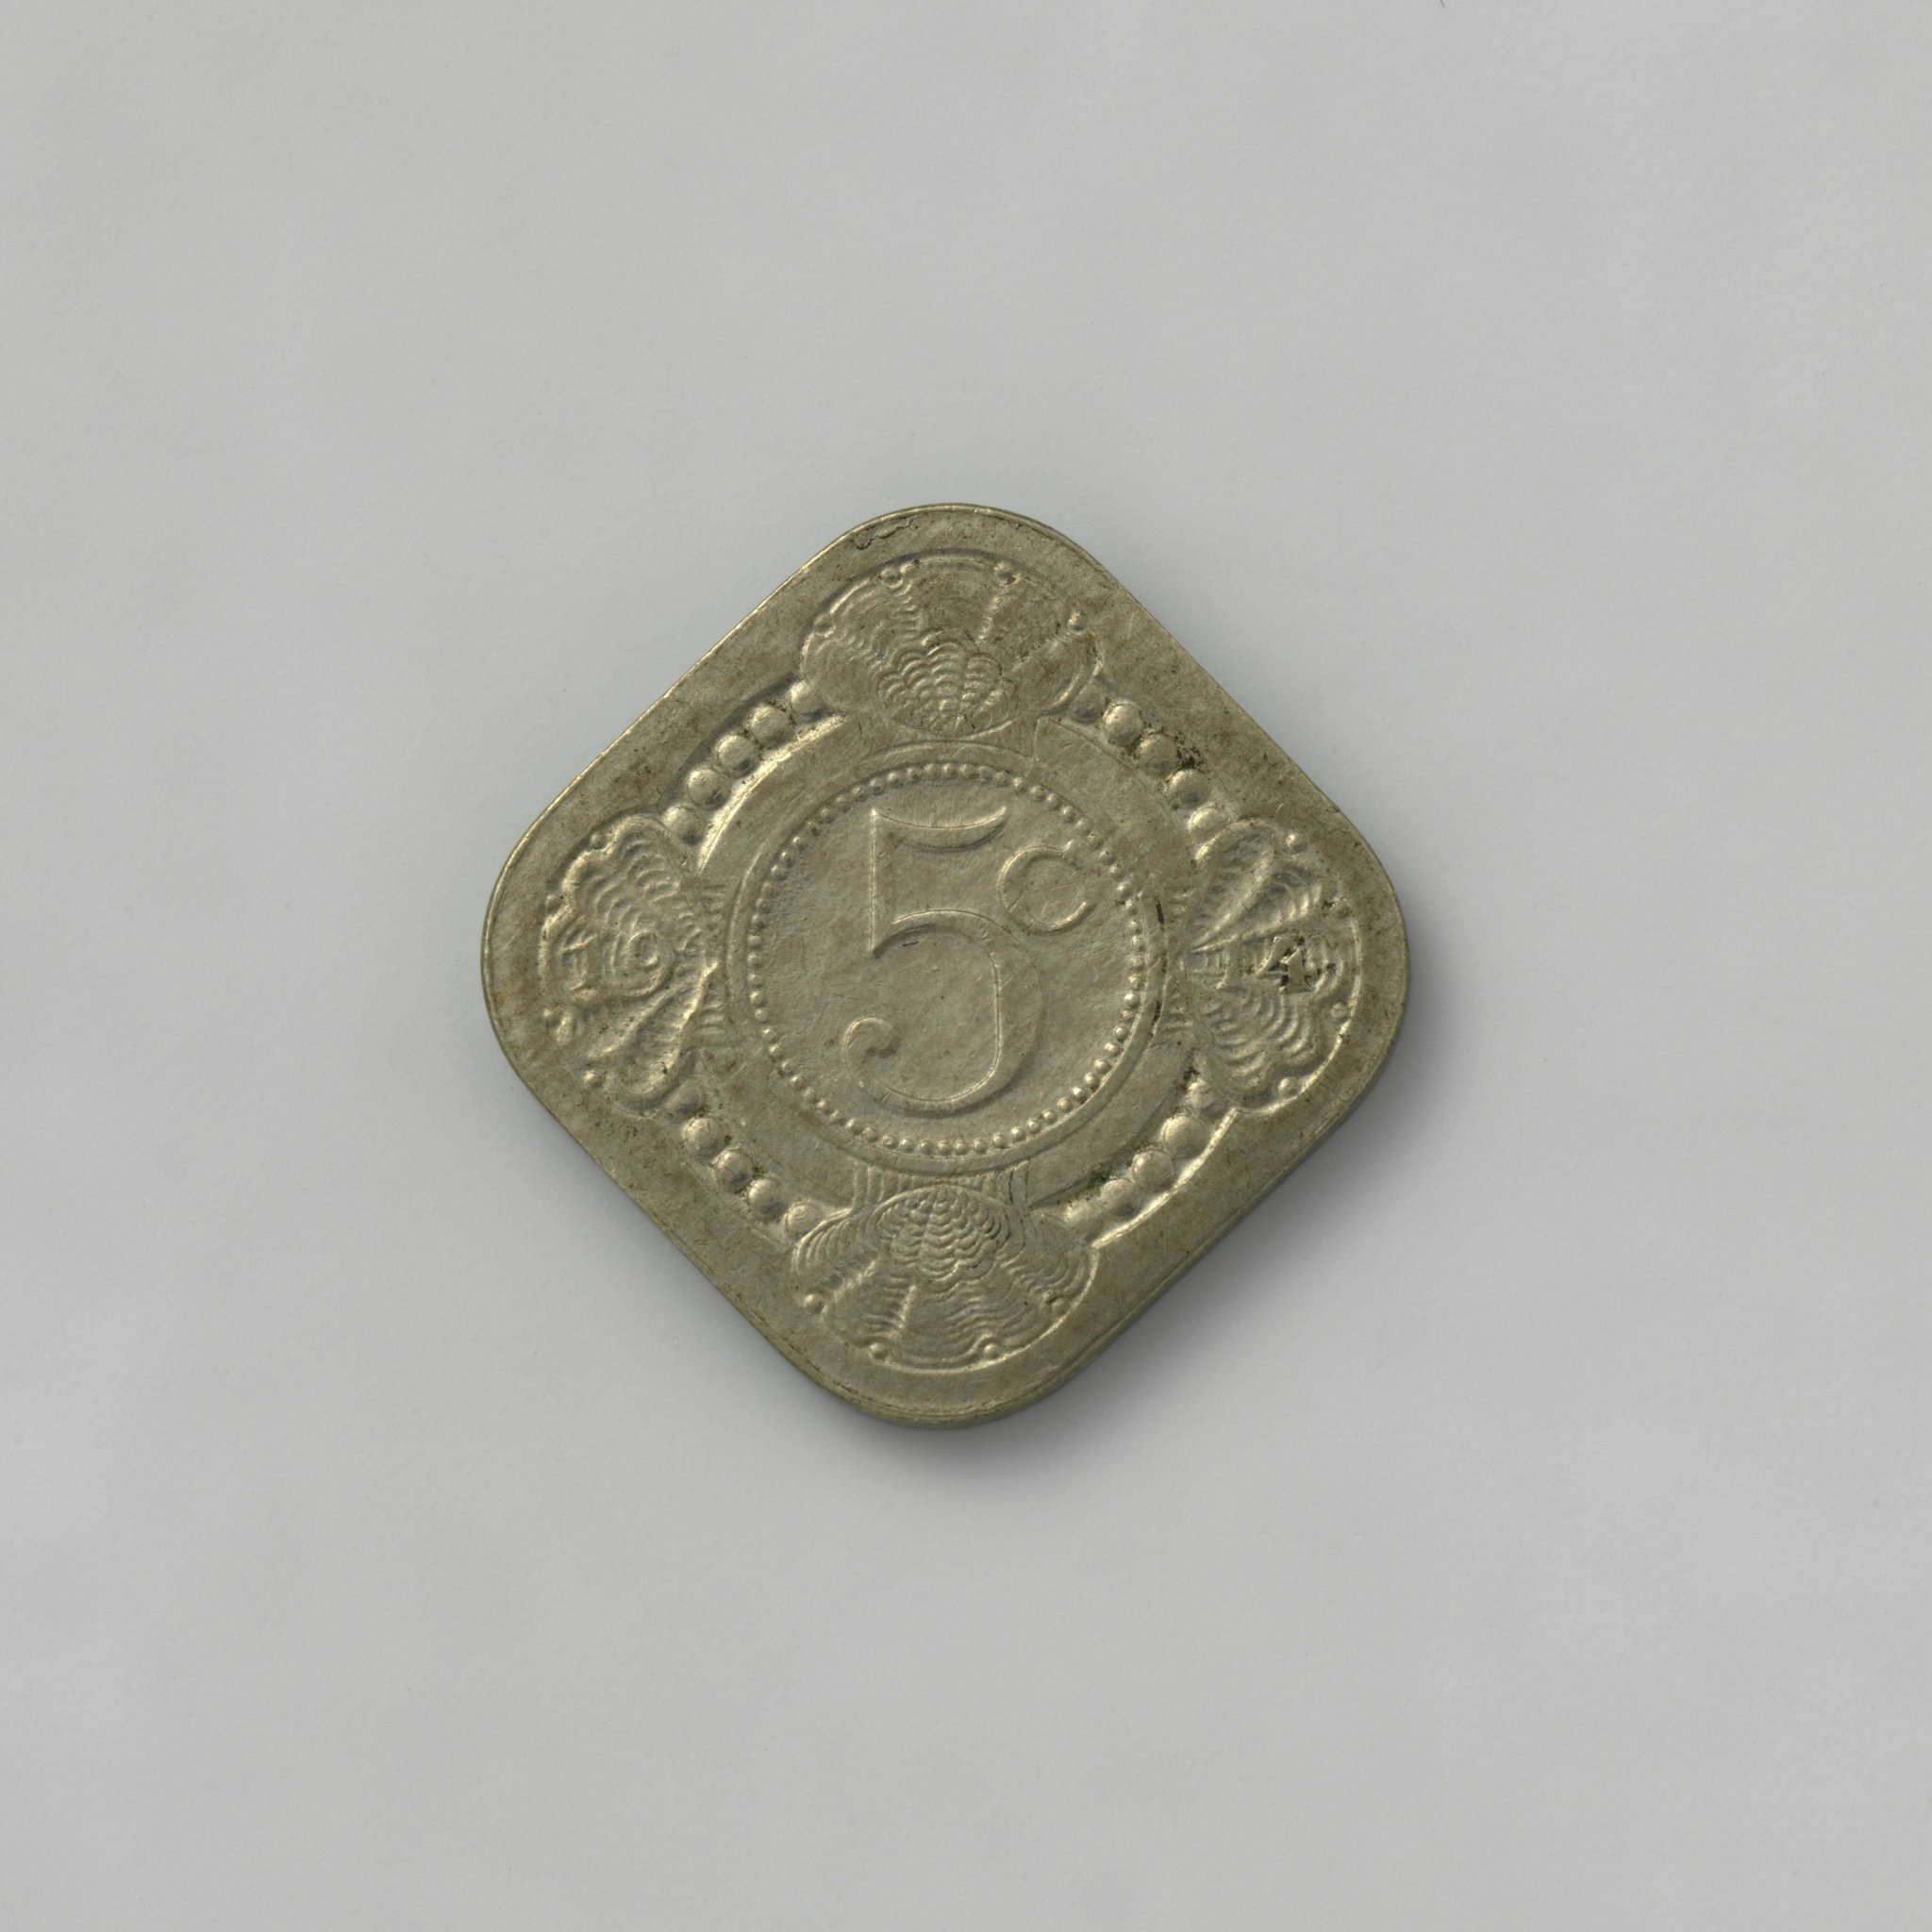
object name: vijf cent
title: Nederland, 5 cent, 1914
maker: wilhelmina of the netherlands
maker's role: print maker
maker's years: 1880-1962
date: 1914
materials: nickel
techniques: striking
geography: utrecht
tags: netherlands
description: Vierkante nikkelen munt. Voorzijde: in hoeken versiering, daarbinnen twee cirkels, waarin landsaanduiding. Daarbinnen vruchtdragende tak van een oranje-appel. Keerzijde: in de vier hoeken schelpen-versiering, verbonden door parels. Daarbinnen waarde-aanduiding 5 C in parelrand. Jaartal in de twee schelpen links en rechts. Gladde rand.